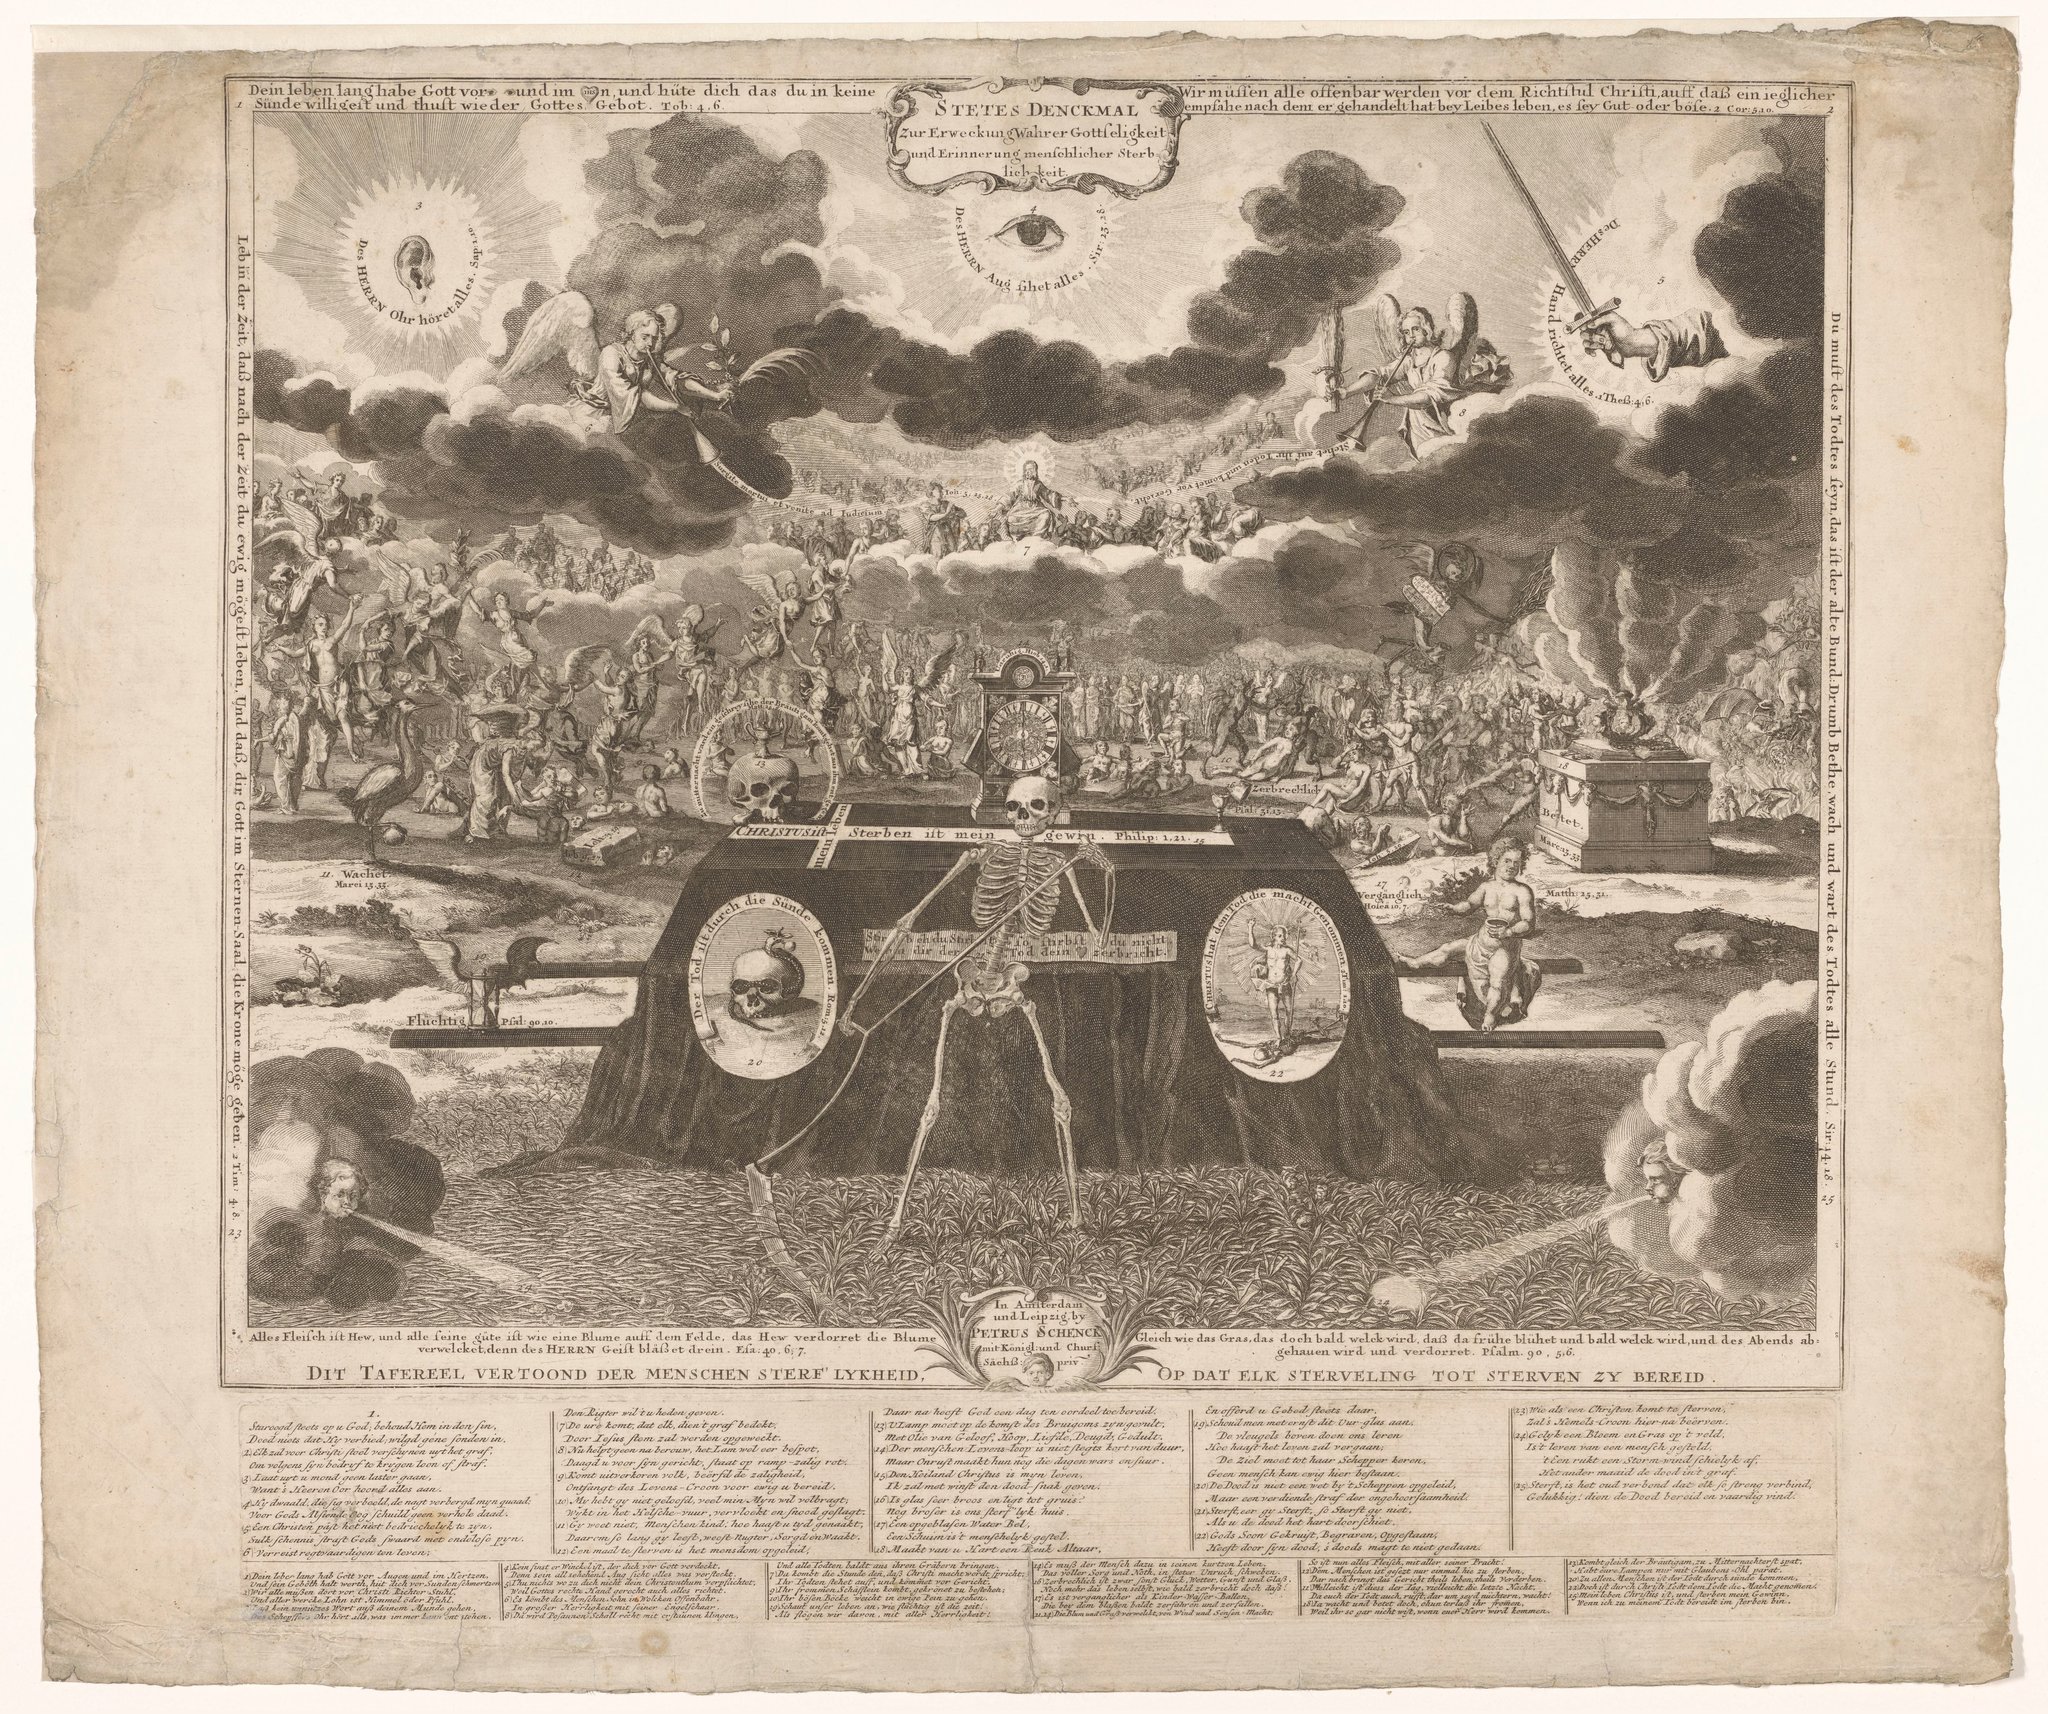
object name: print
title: Allegory of Transience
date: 1690-1711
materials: paper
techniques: etching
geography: leipzig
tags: agricultural implements: scythe, scenes symbolizing 'vanitas', death as skeleton, comprehensive representation of last judgement: christ (with sword and lily), often surrounded by elders and sometimes accompanied by mary and john the baptist, appears in the sky with trumpeting angels (and sometimes angels holding the instruments of the passion); after the resurrection of the dead the blessed are led to heaven by angels, and the damned are dragged into hell by devils, clock, coffin, ears, the all-seeing eye, triangle with eye ~ symbol of god the father, hand, 'dextera dei' ~ symbol of god the father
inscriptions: collector's mark: Lugt 2228, collector's mark: Lugt 2760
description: Allegorie op de vergankelijkheid met de Dood als maaier met zeis. De Dood voor een lijkkist op een draagbaar met bovenop een klok. Op de achtergrond het Laatste Oordeel. Centraal bovenin de hemel het Alziende Oog van God, links het alles horende oor van God en rechts de alles oordelende rechterhand van God met zwaard. In de voorstelling vele verwijzingen naar Bijbelteksten. Met van aparte plaat gedrukte legenda met toelichtingen in het Nederlands en Duits.